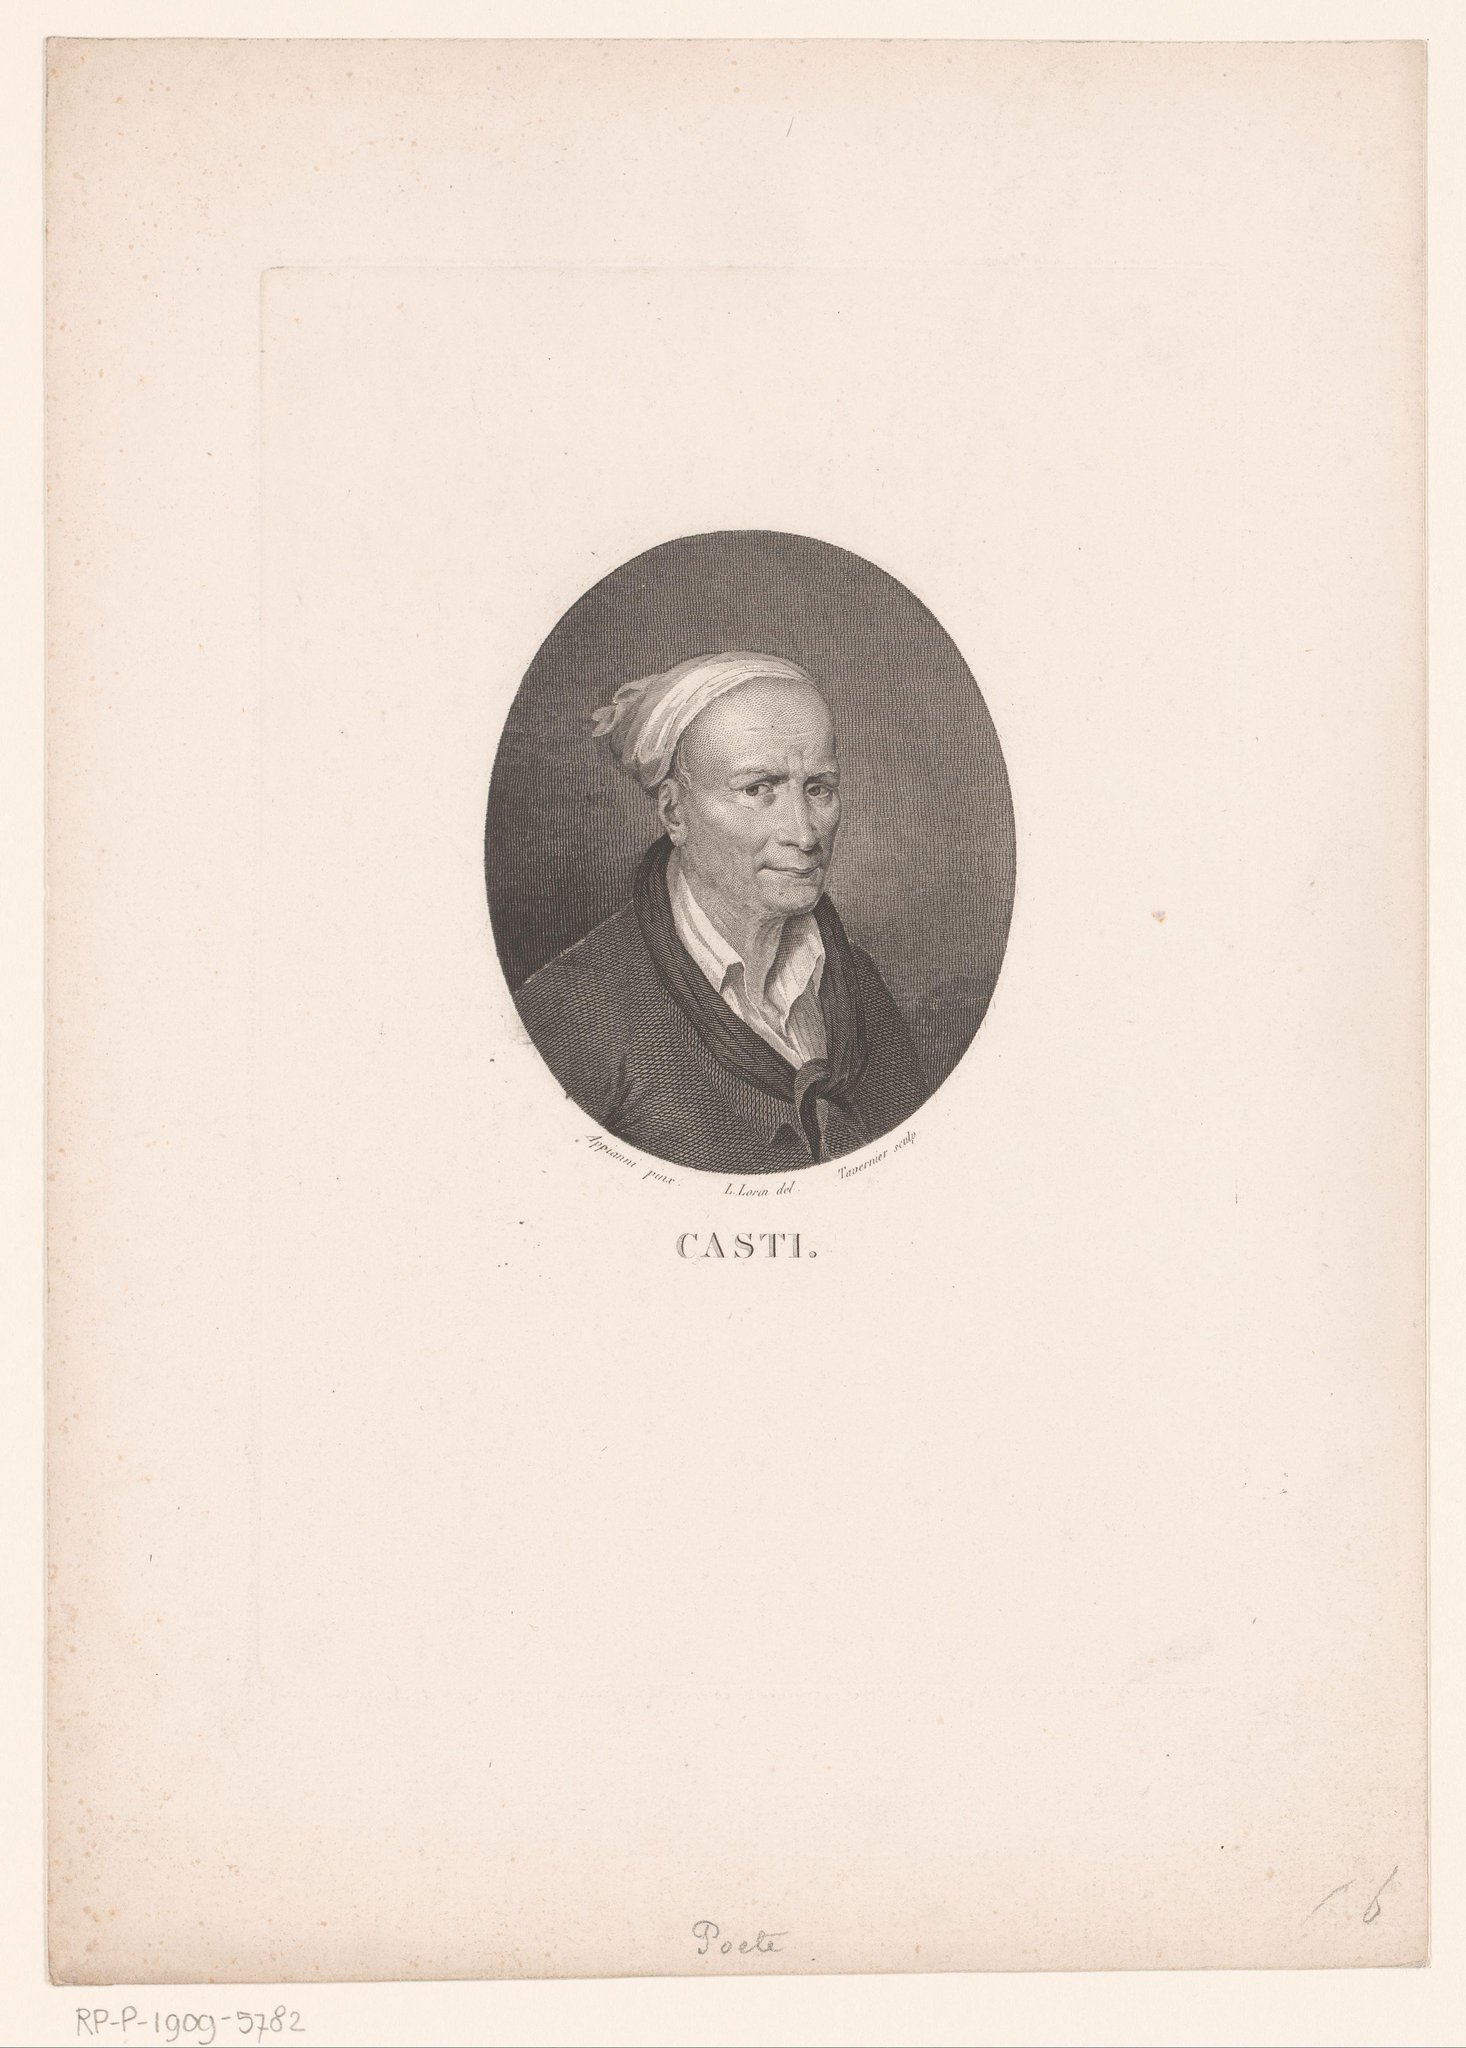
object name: print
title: Portret van Giovanni Battista Casti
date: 1797-1845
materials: paper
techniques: etching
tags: historical persons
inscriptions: collector's mark: Lugt 2228